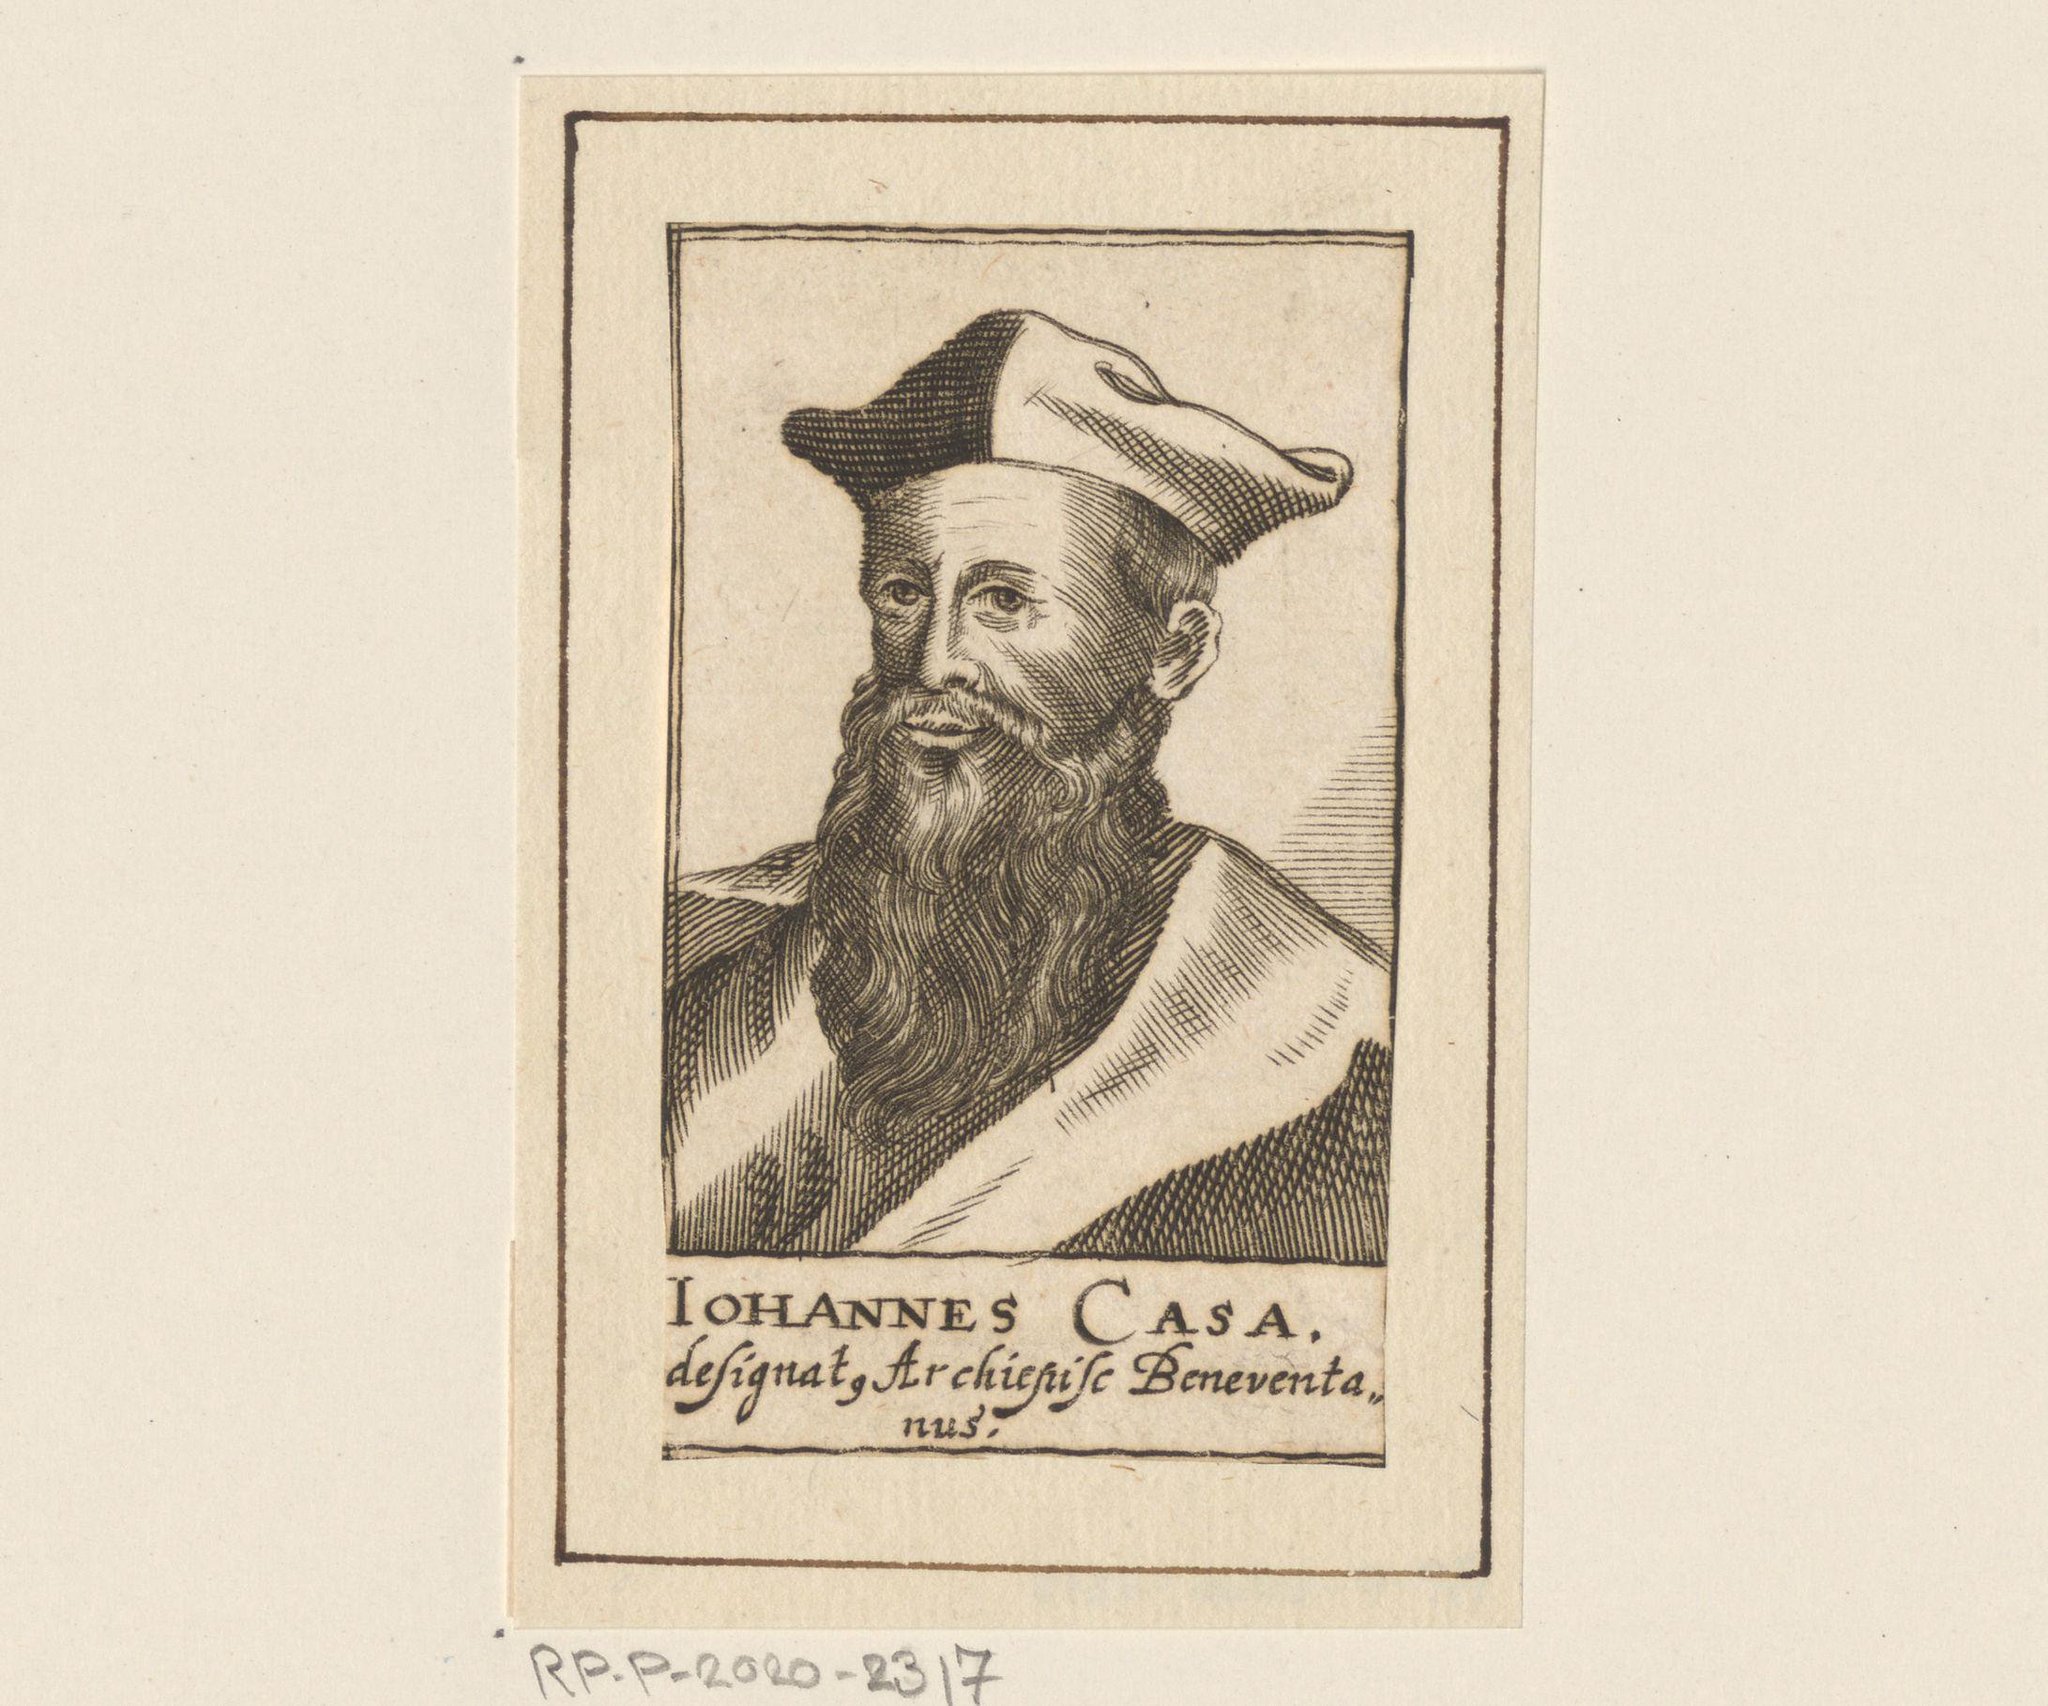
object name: book illustration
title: Portret van Giovanni della Casa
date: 1688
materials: paper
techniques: engraving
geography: nuremberg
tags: historical persons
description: Prent waarschijnlijk uit: Freher, Paul. Theatrum virorum eruditione clarorum. Neurenberg: Johann Hoffmann, 1688.